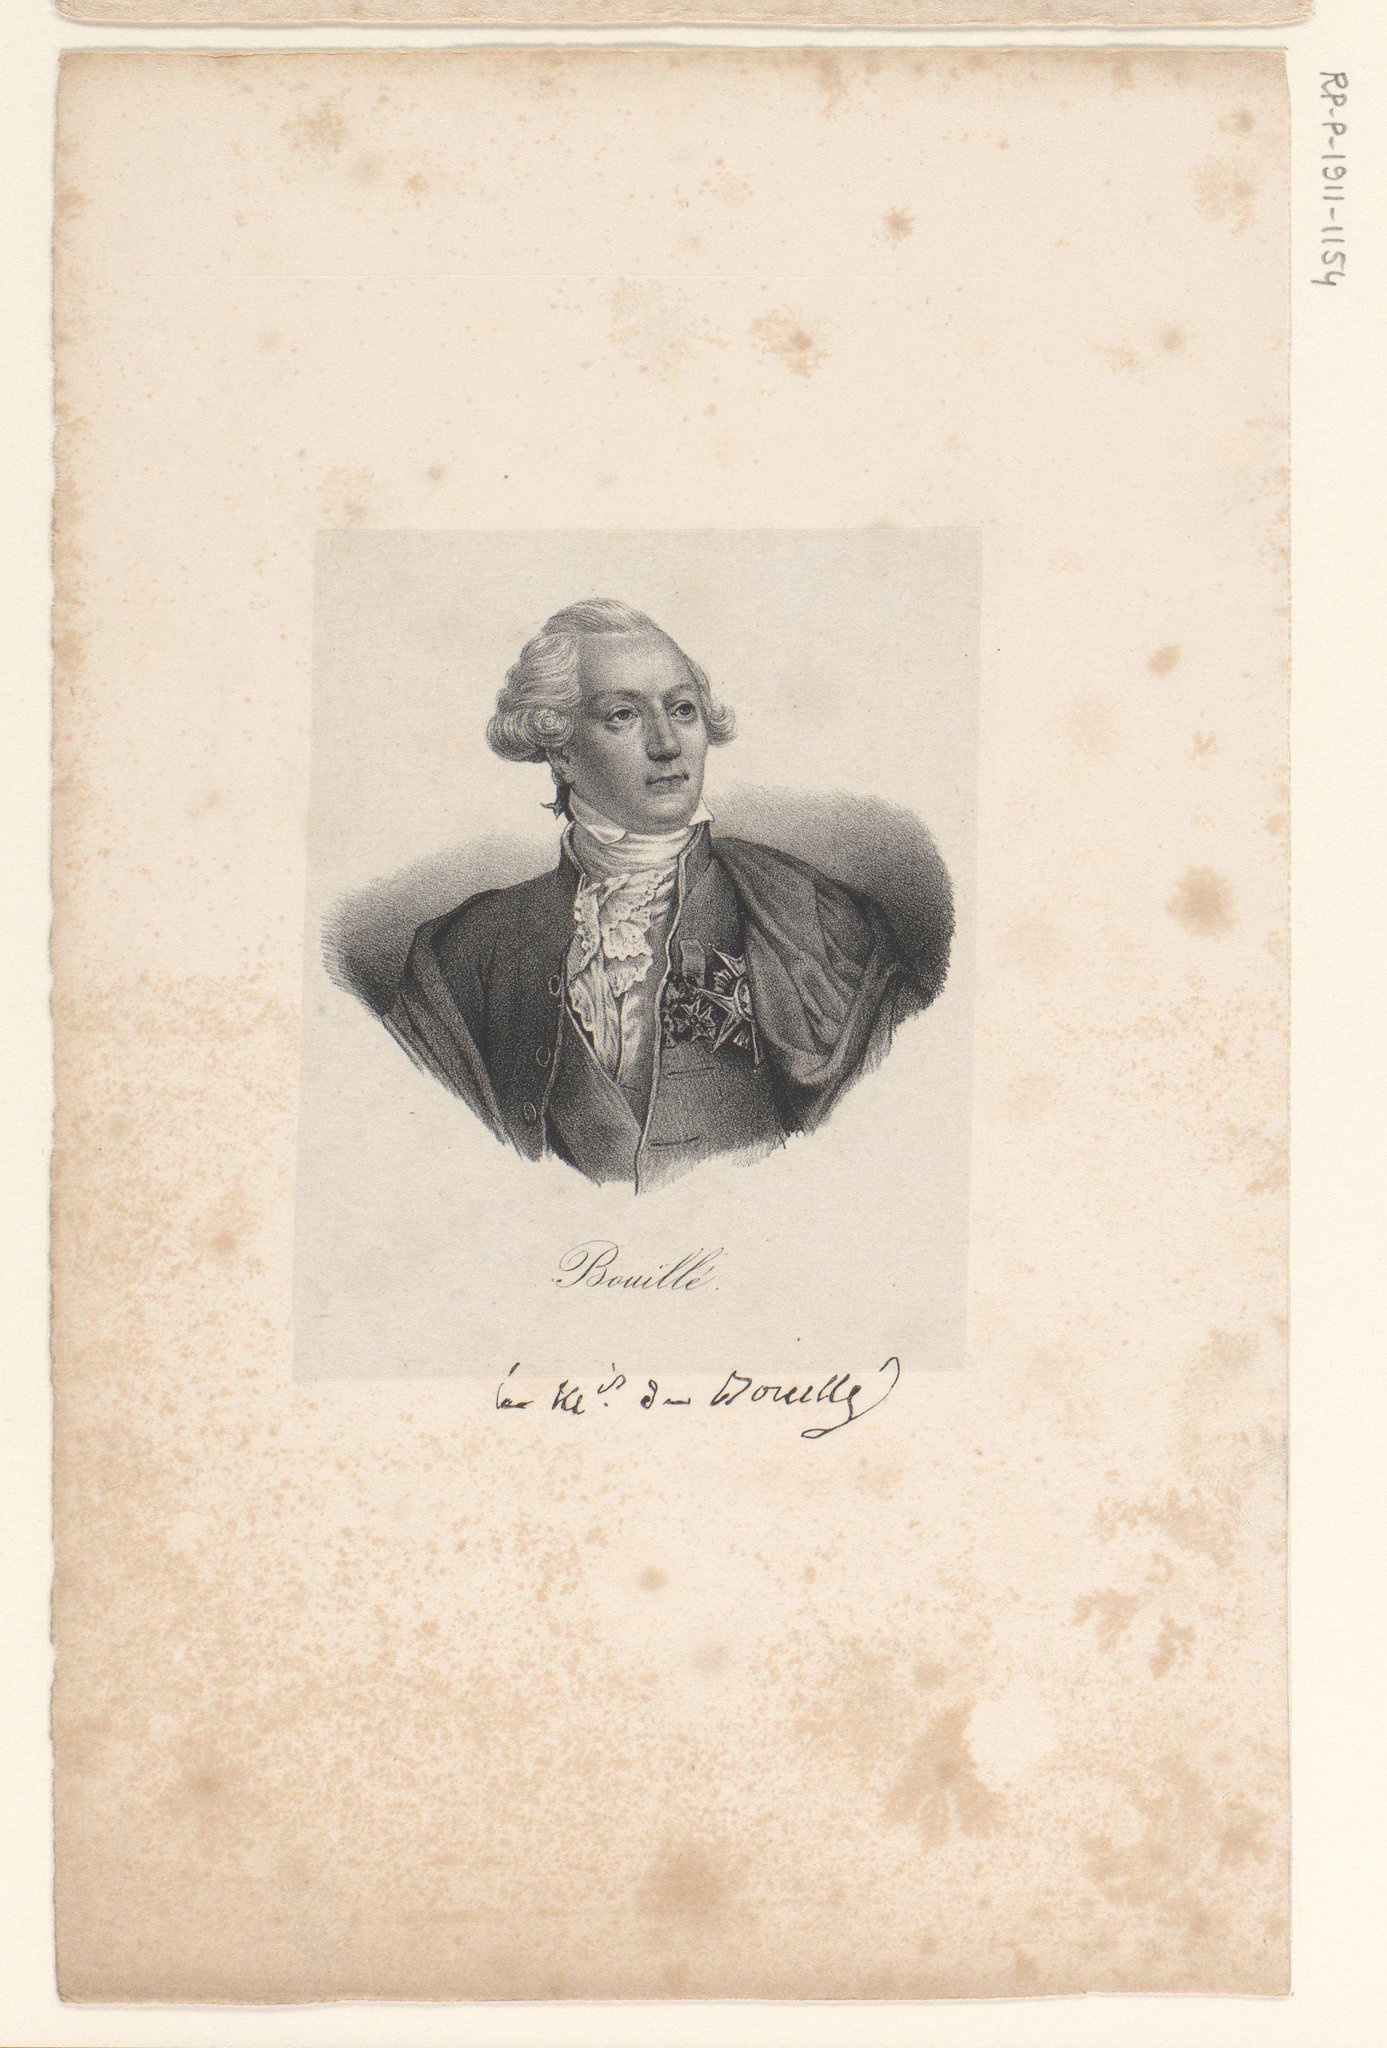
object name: print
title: Bouillé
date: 1823-1842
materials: paper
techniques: lithograph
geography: paris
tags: historical persons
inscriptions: collector's mark: Lugt 2228a